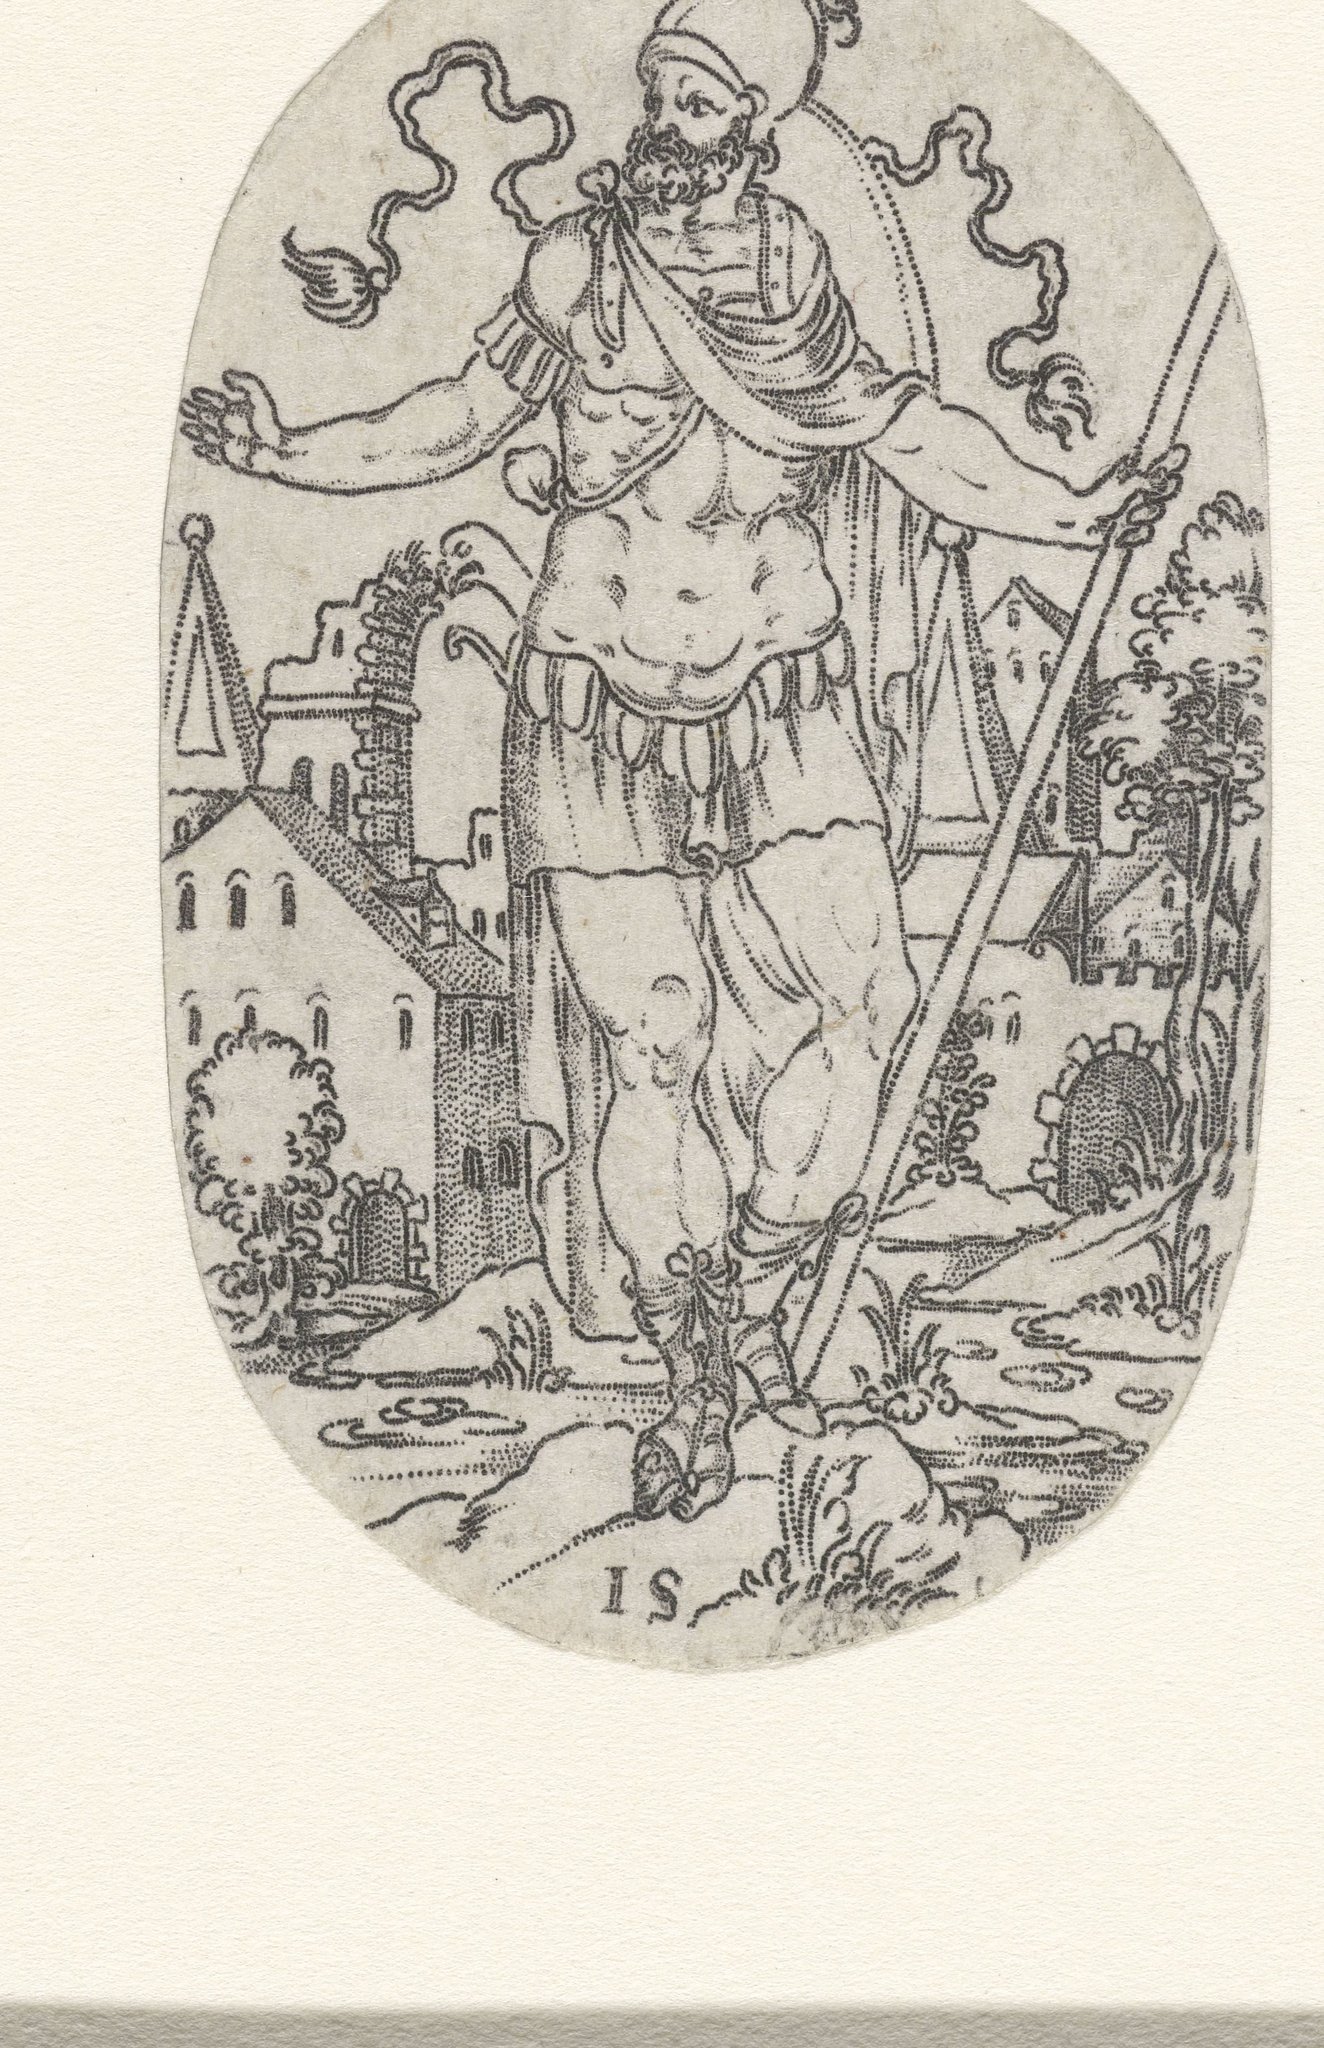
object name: print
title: Antieke held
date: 1572-1589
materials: paper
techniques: engraving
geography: germany